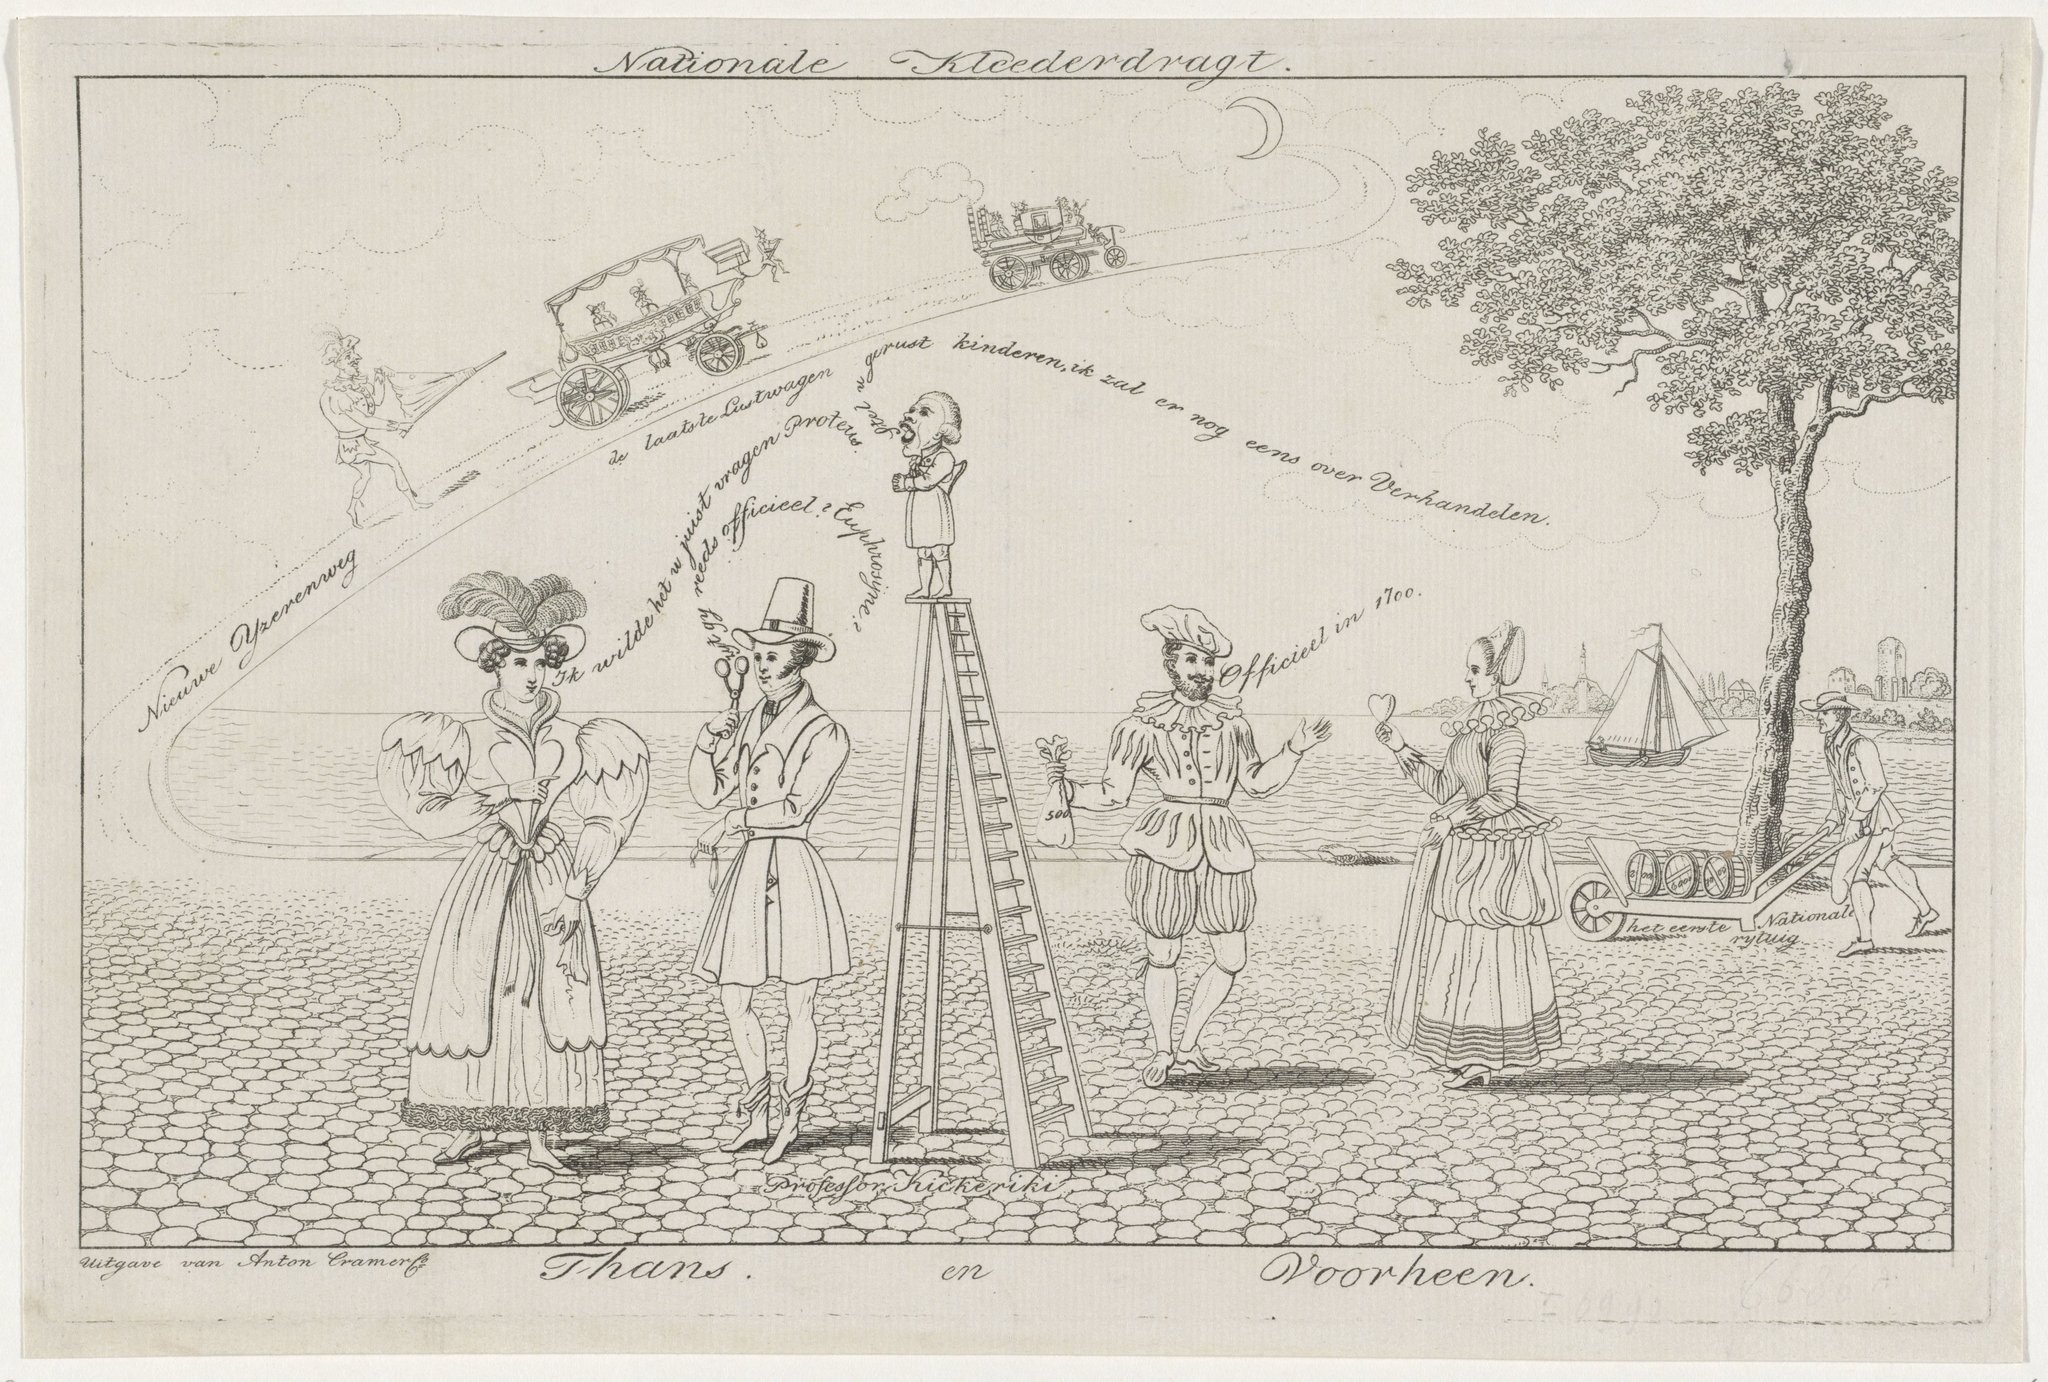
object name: cartoon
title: Nationale Kleederdragt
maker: Anonymous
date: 1831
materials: paper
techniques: etching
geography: netherlands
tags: amsterdam, willem hendrik warnsinck, machine driven by steam, bus, coach (+ propulsion of vehicle, ship, etc. by steam), folk costume, regional costume, fashion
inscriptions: collector's mark: Lugt 2228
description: Spotprent op de mislukte pogingen van de Amsterdamse dichter en suikerraffinadeur W.H. Warnsinck om tijdens de Belgische Opstand een nationale Nederlandse klederdracht in te voeren, 10 juli 1831. Straatbeeld waarin een man en een vrouw gekleed volgens nieuwe voorstellen aan elkaar vragen of zij al officieel zijn. Bovenaan een trap een klein roepend mannetje 'Professor Kickeriki' (= Warnsinck). Door de lucht loopt omhoog de 'Nieuwe IJzerenweg' waaroverheen een stoomdiligence en de 'laatste Lustwagen' voortgeblazen met een blaasbalg richting de maan rijden.